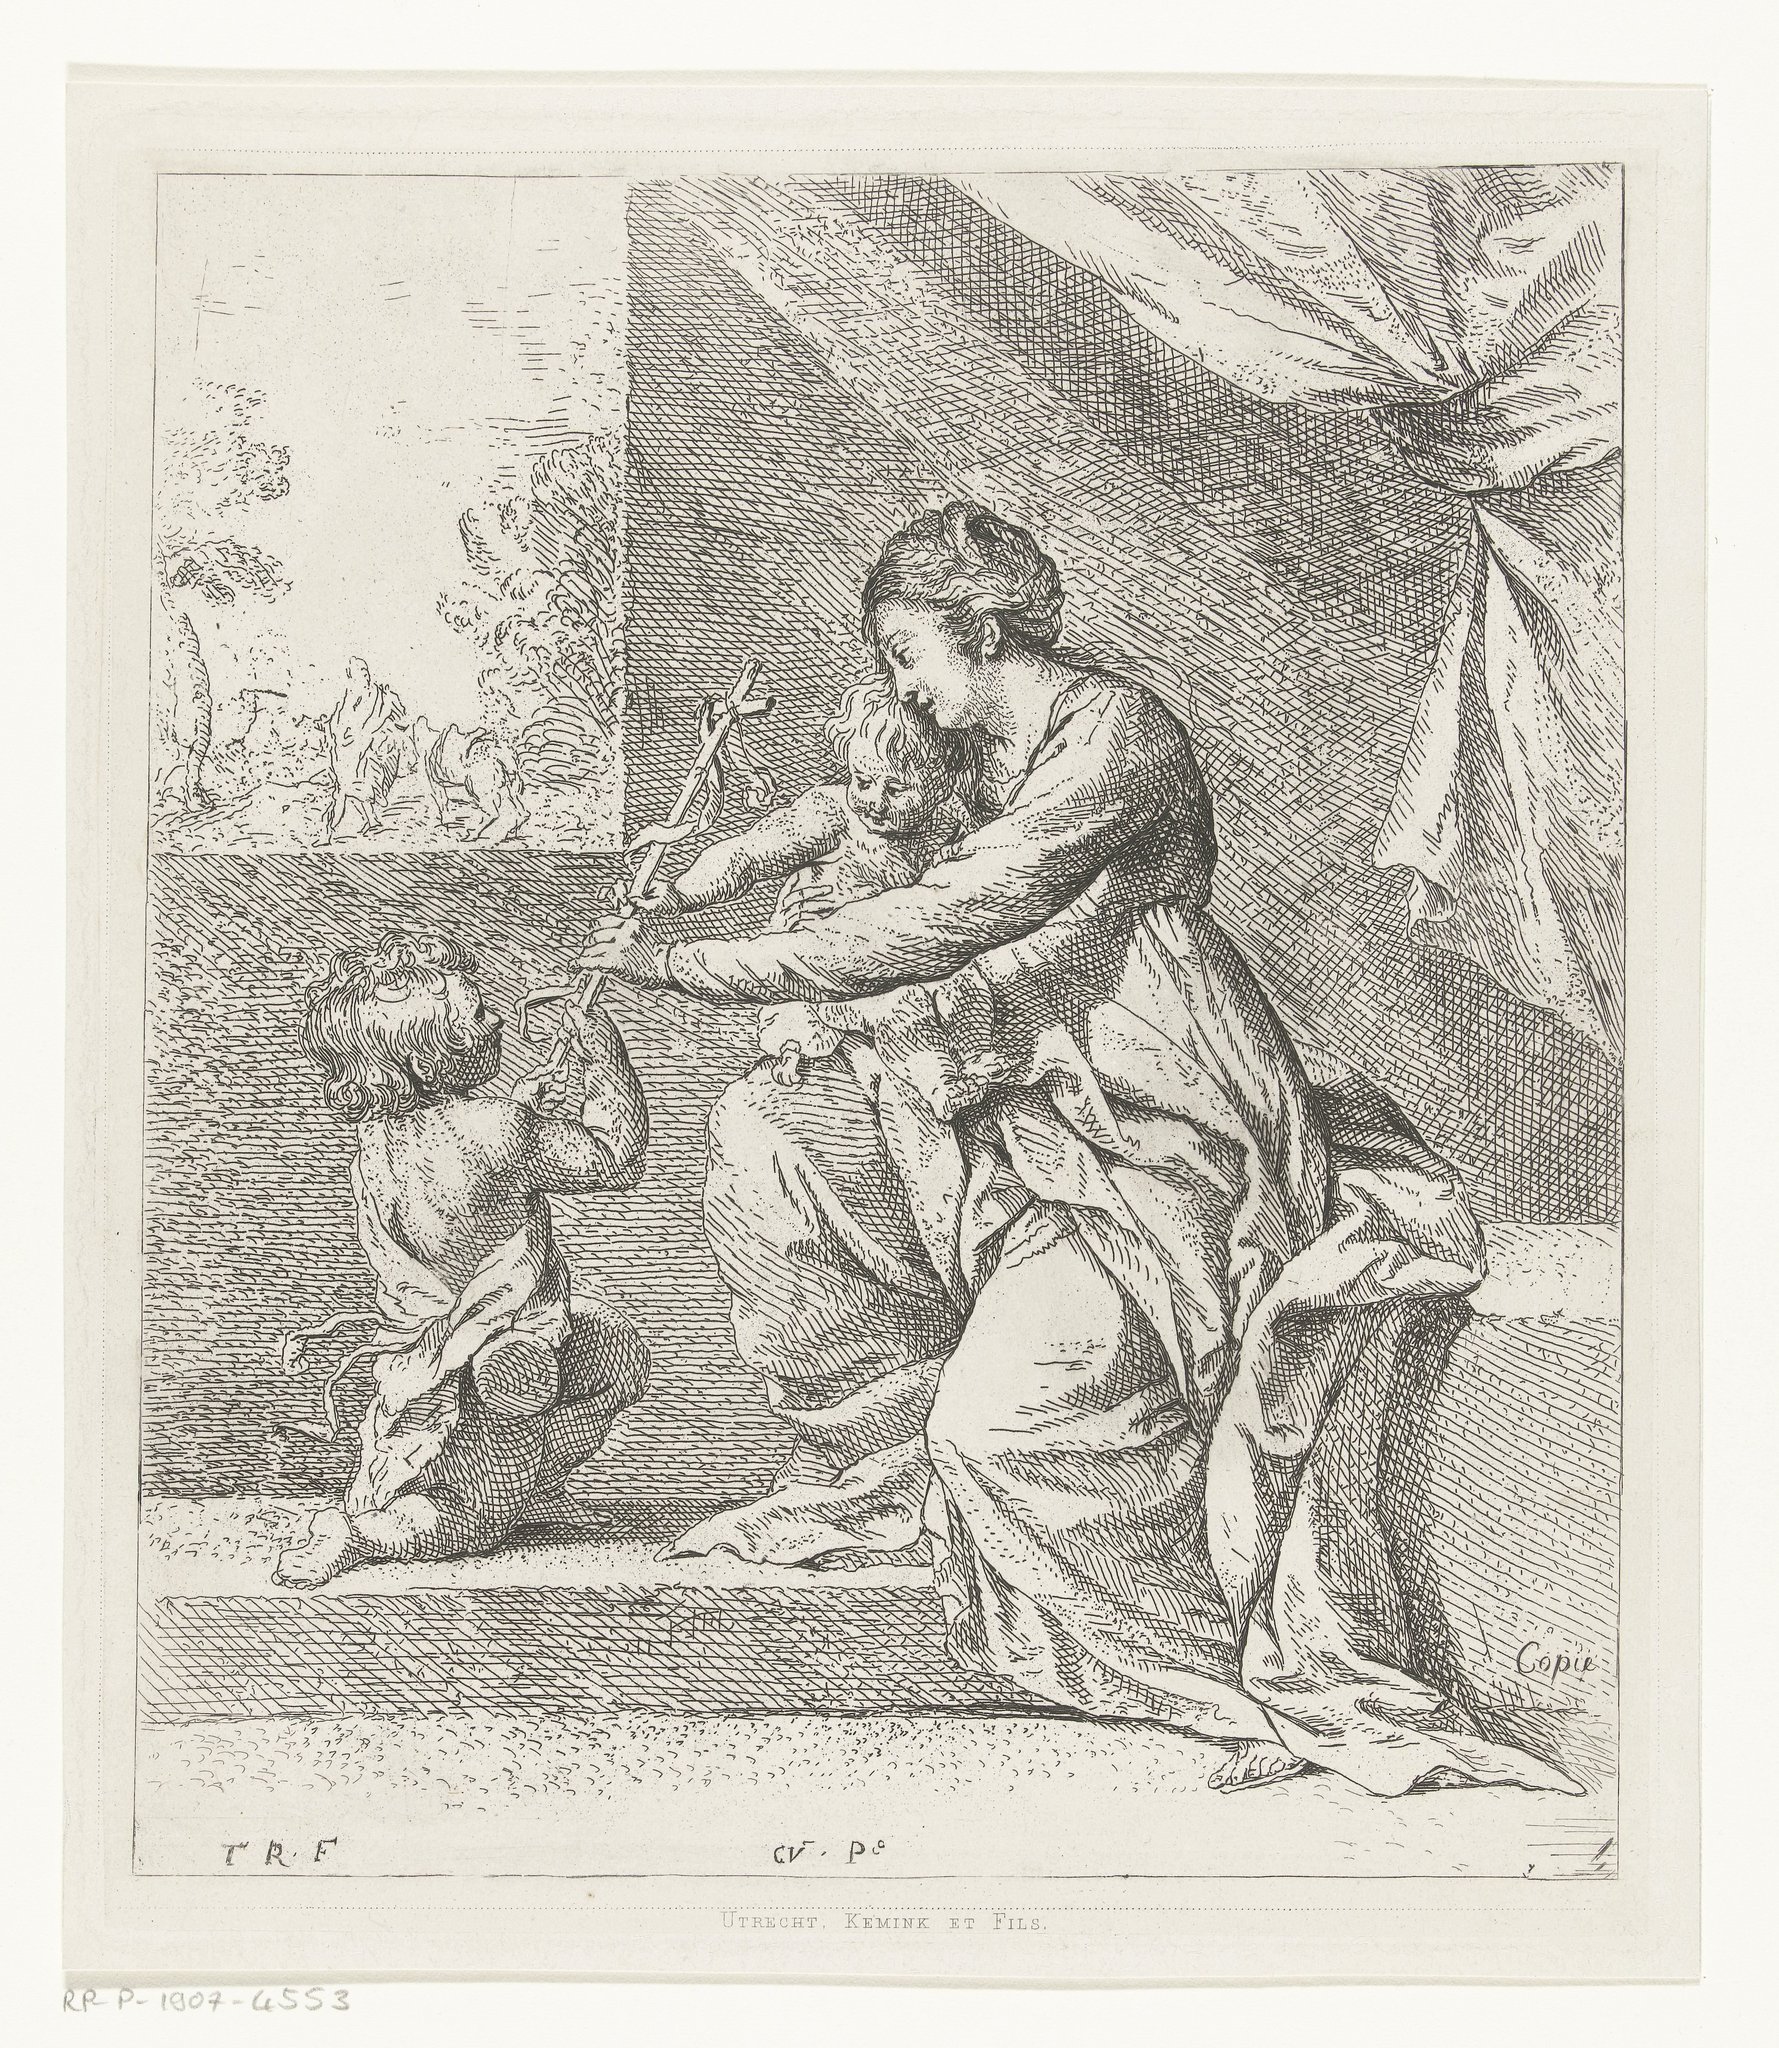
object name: print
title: Heilige familie met Johannes de Doper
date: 1866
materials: paper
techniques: etching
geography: utrecht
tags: holy family with john the baptist (as child)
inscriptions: collector's mark: Lugt 2228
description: Illustratie voor J.P. van der Kellen, Le peintre graveur hollandais et flamand, Utrecht: 1866.